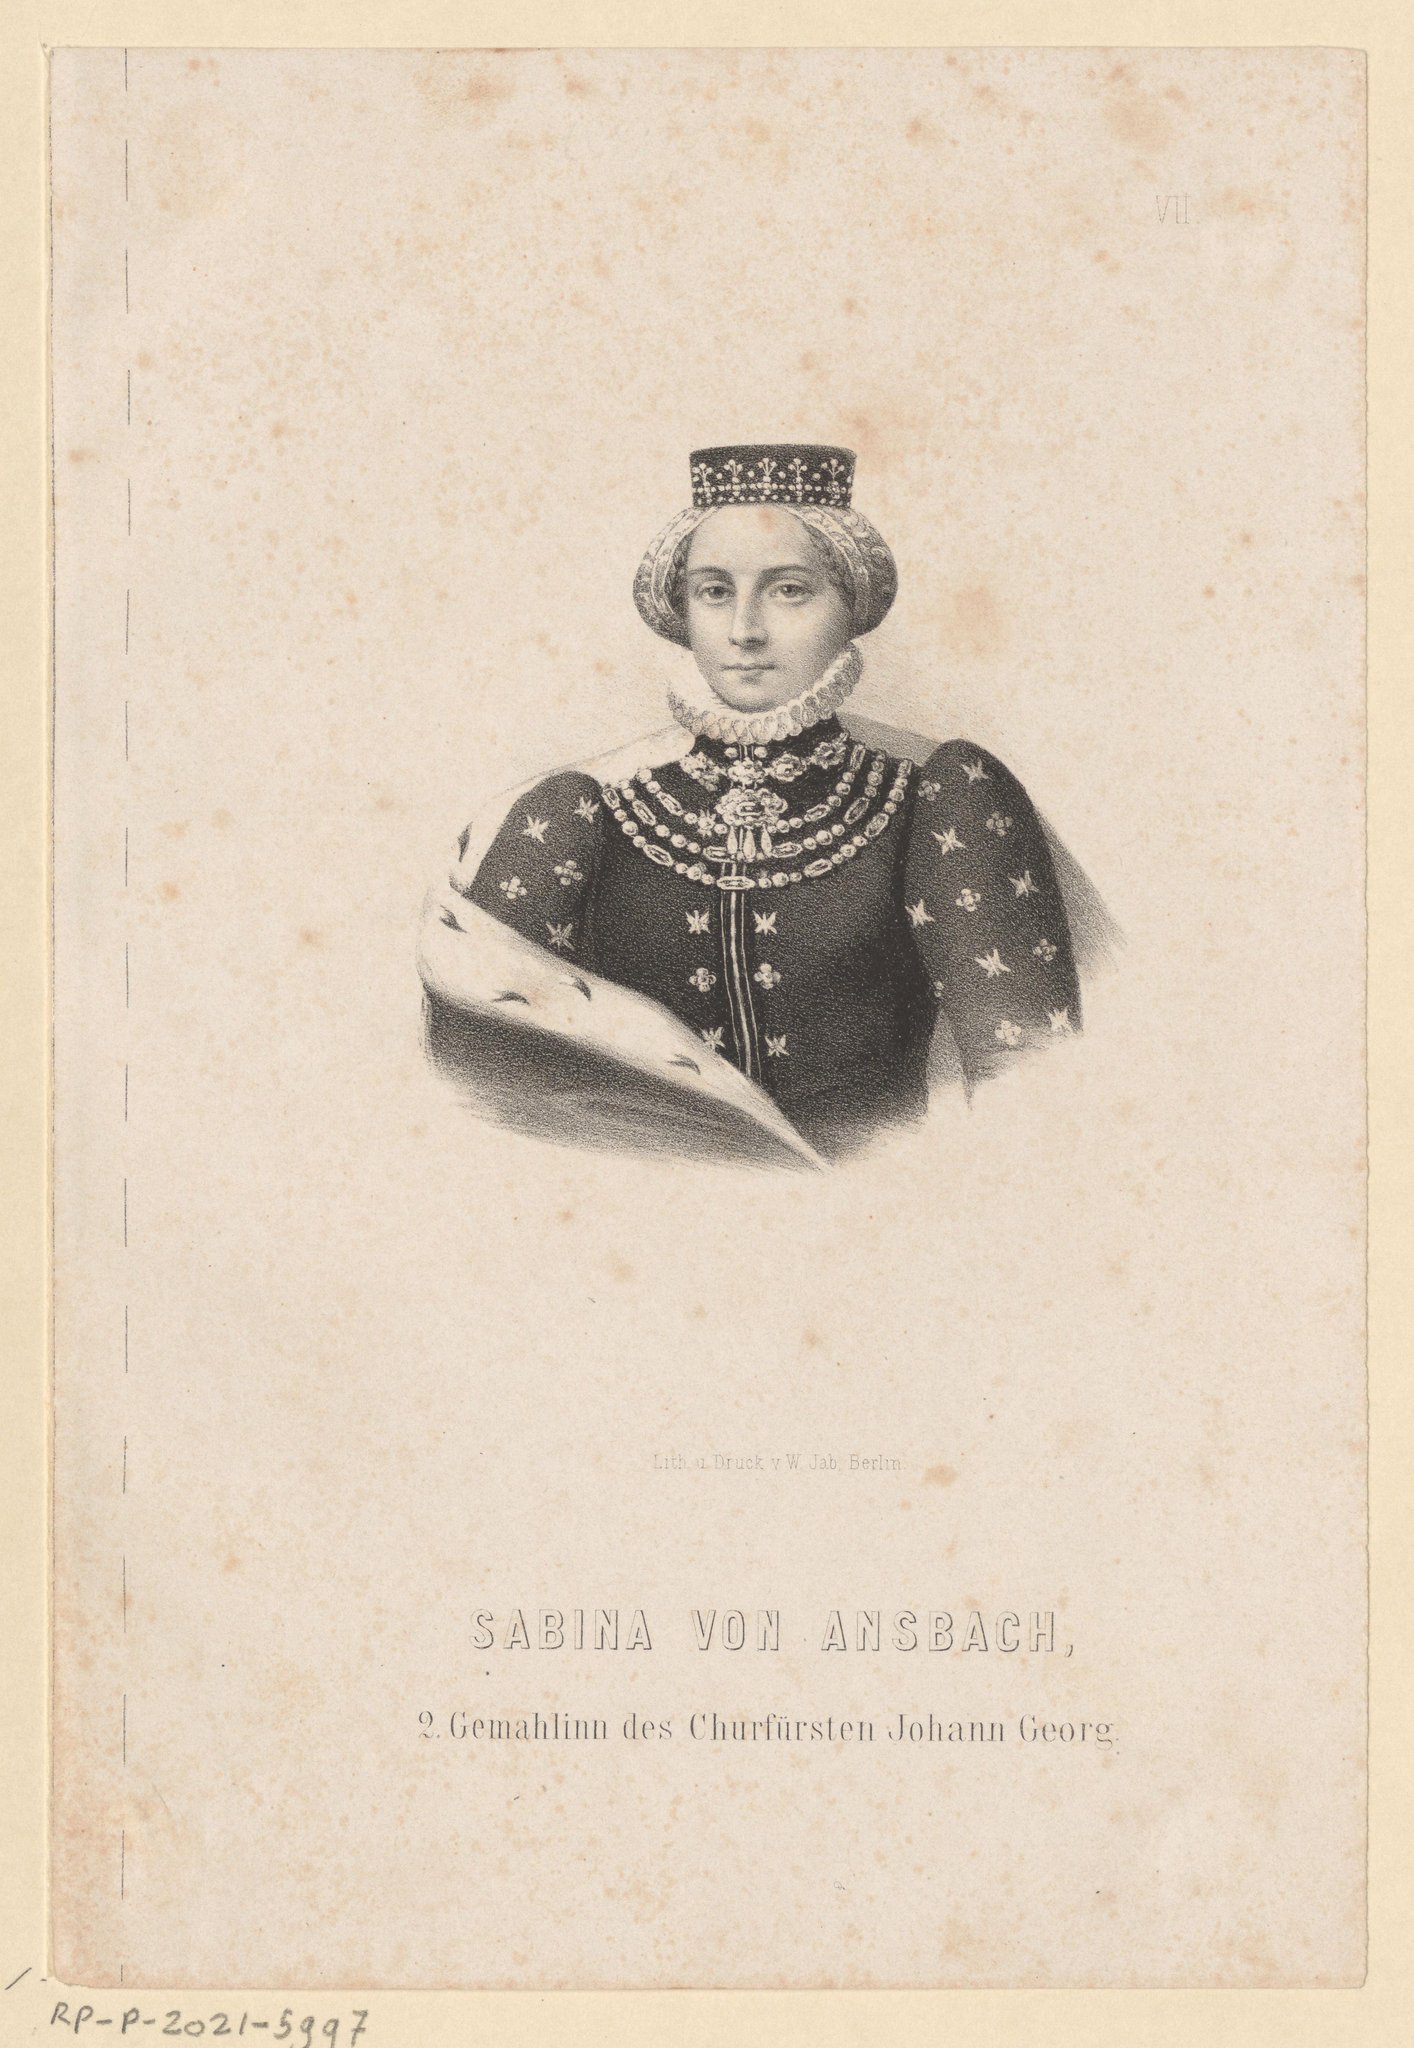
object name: print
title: Portret van Sabina von Ansbach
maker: wilhelm jab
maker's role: print maker, printer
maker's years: -1871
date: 1800-1871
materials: paper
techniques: lithograph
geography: berlin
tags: berlin, historical persons - bb - woman